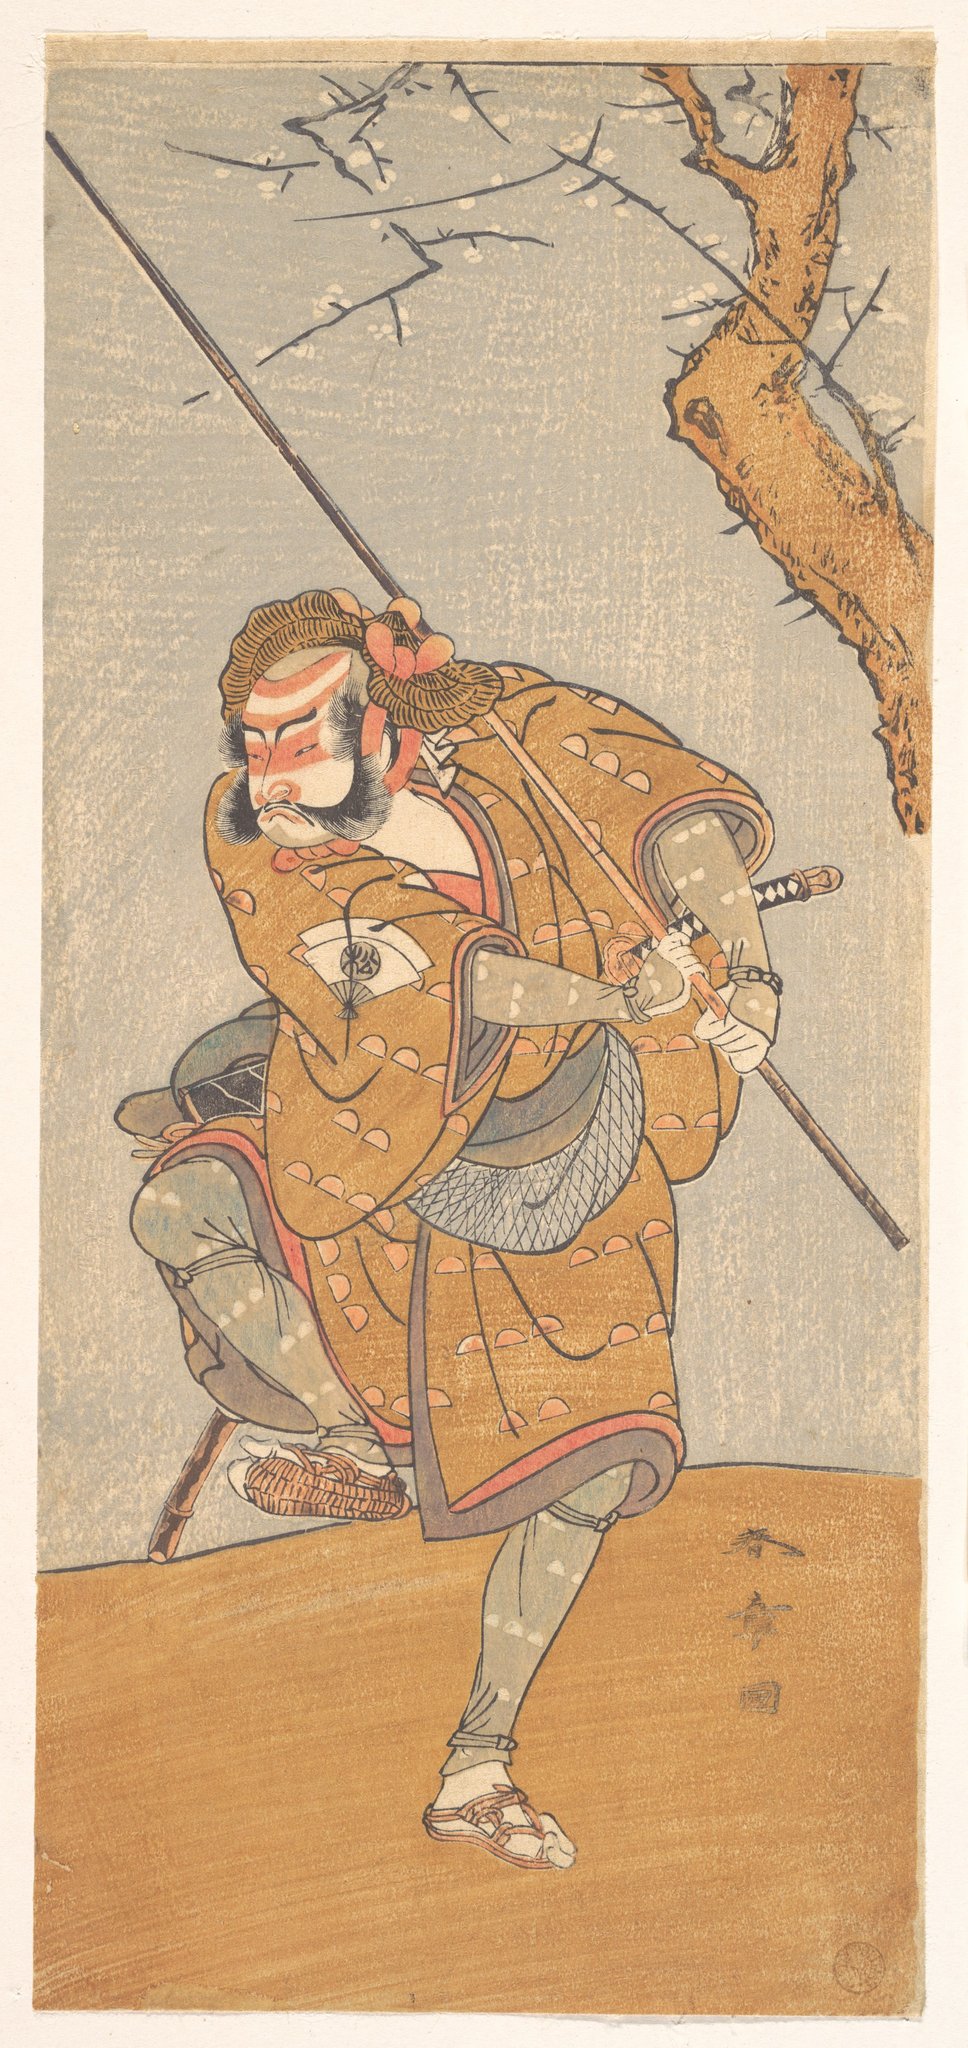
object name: woodblock print nishiki e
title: Onoe Matsusuke in the Role of Asahina in "Edo no Haru Meisho Soga"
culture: japanese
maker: katsukawa shunshō 勝川春章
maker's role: artist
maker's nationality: japanese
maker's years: 1726-1792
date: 1773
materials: ink, paper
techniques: nishiki e, woodblock print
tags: men,actors